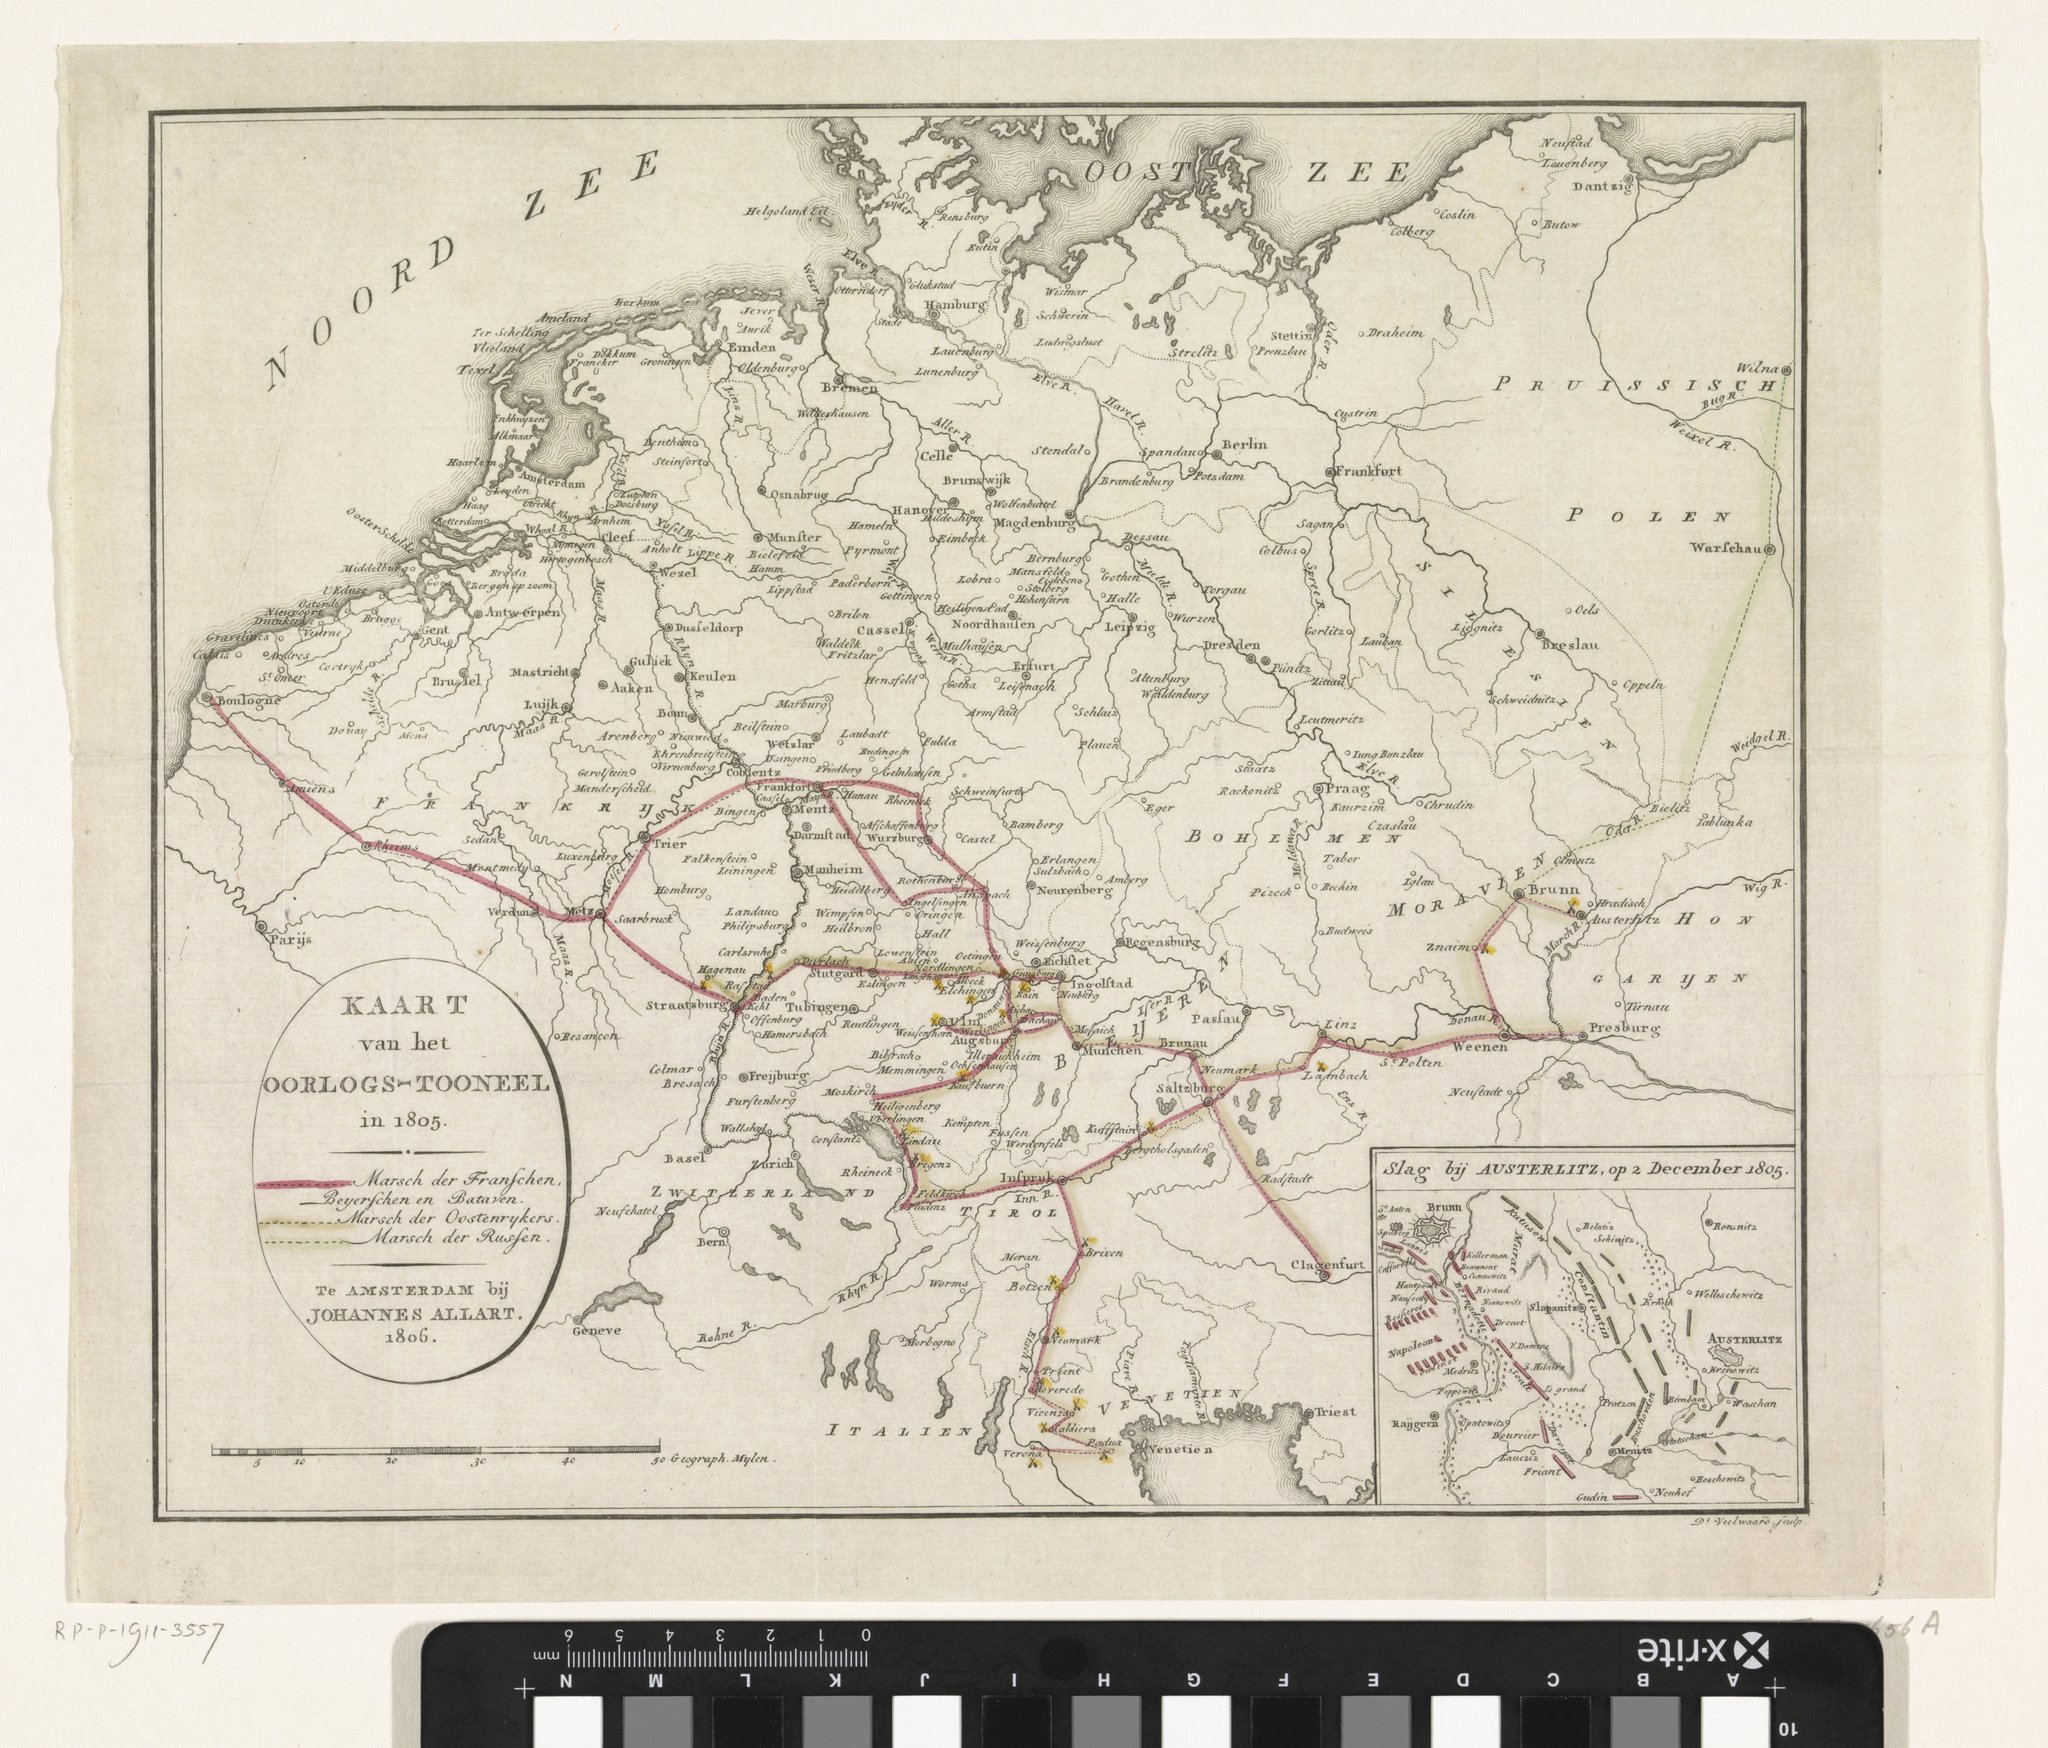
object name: print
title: Kaart van Oorlogs-tooneel in 1805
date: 1806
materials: paper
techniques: engraving, etching, hand coloring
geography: amsterdam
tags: maps of separate countries or regions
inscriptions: collector's mark: Lugt 2228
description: Kaart van Europa waarop de marsen of veldtochten van het Franse en Bataafse leger en Oostenrijkers en Russen in het jaar 1805 staan aangegeven. Rechtsonder een inzet met een kaartje van de slagordes van de legers bij Austerlitz (het huidige Slavkov u Brna in Tsjechië) op 2 december 1805.